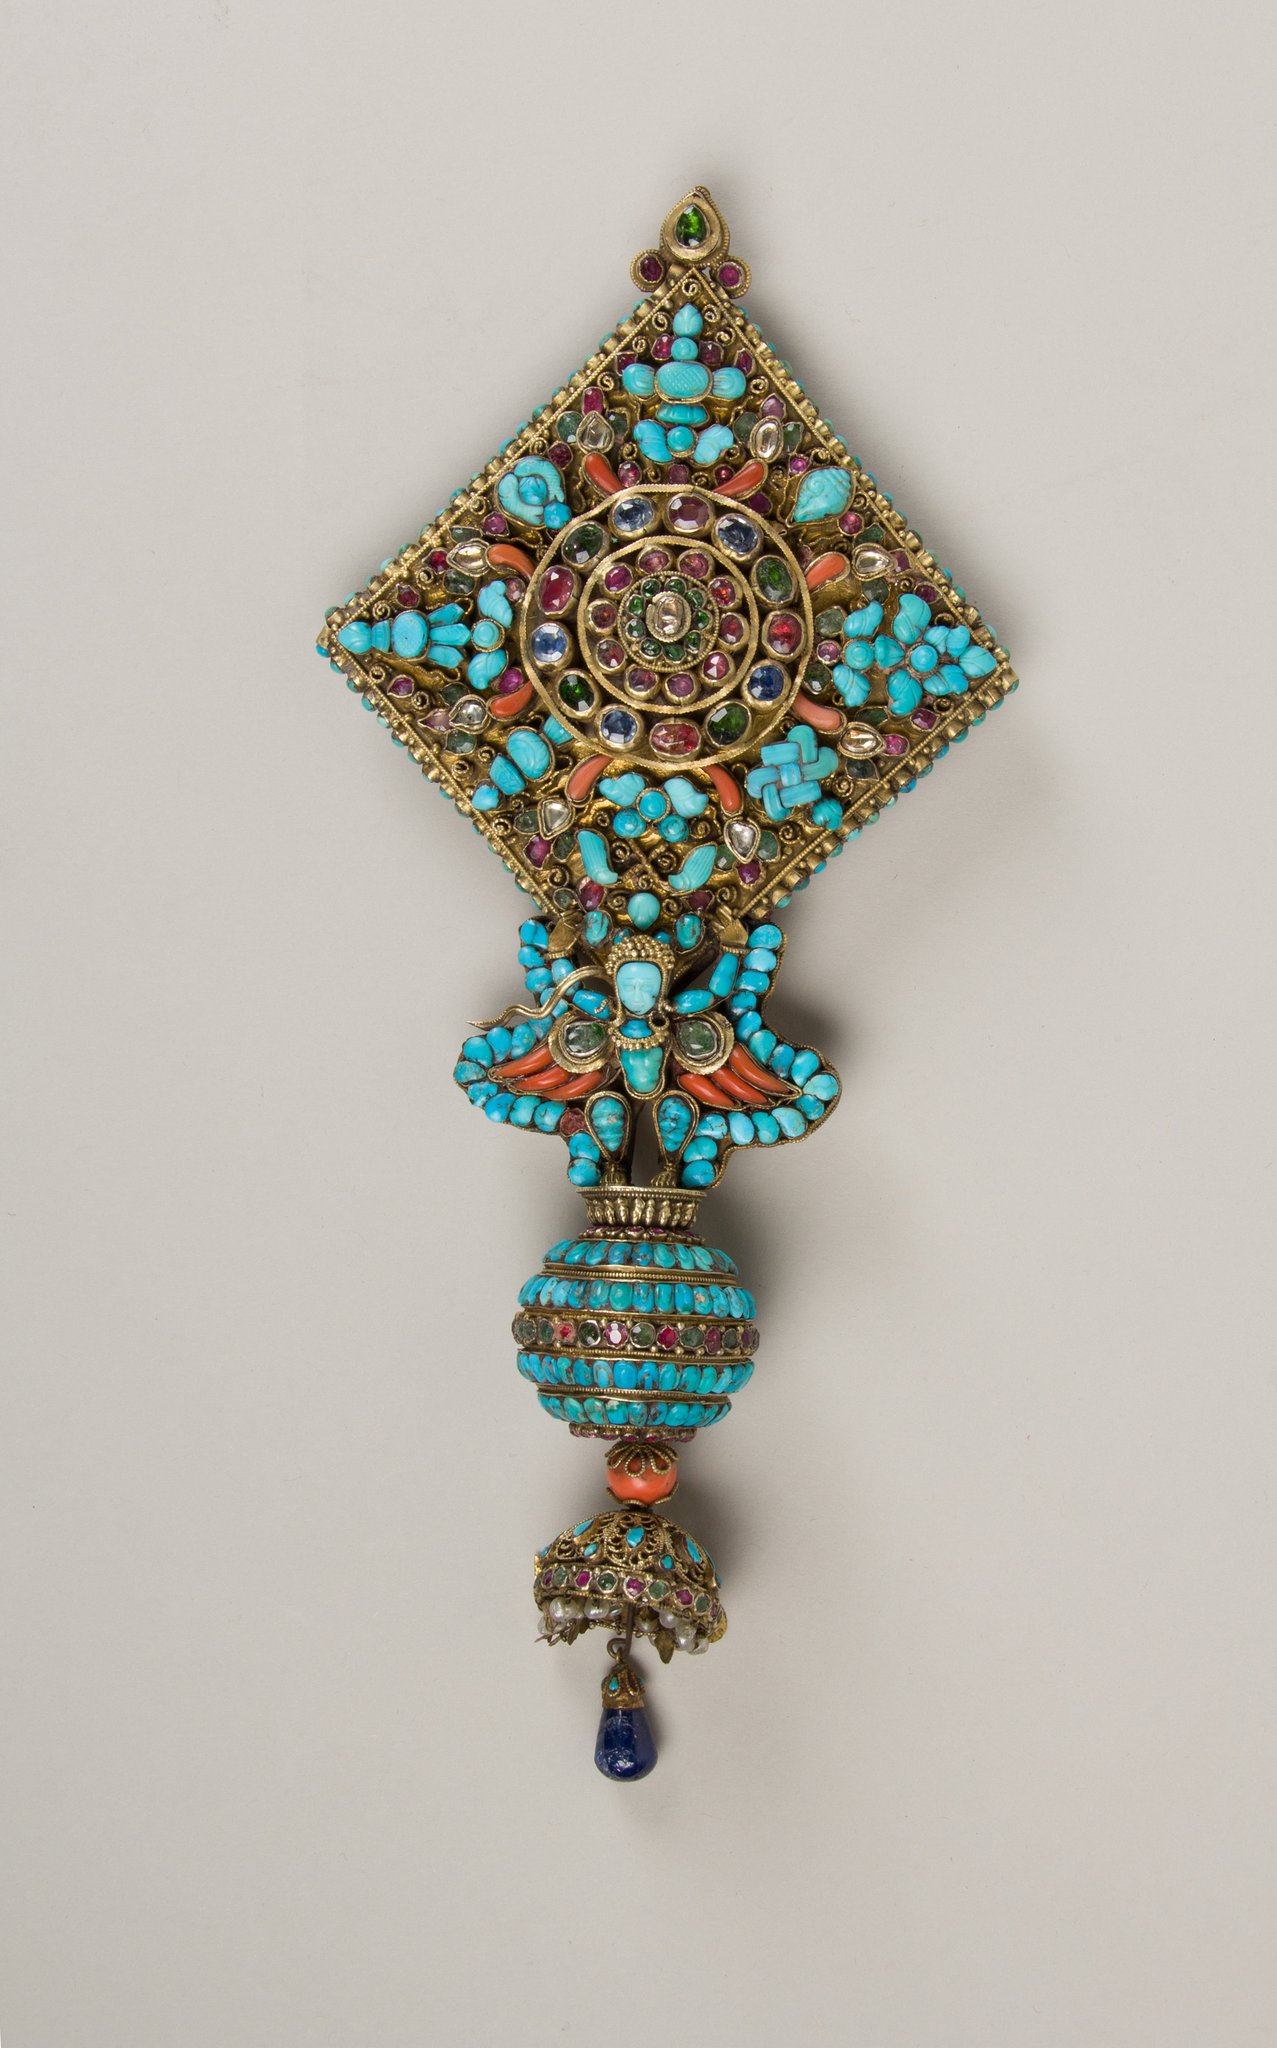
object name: ornament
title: Ear Ornament for a Deity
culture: nepali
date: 1601-1900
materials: coral, gemstone, silver gilt, lapis lazuli, mercury, pearl